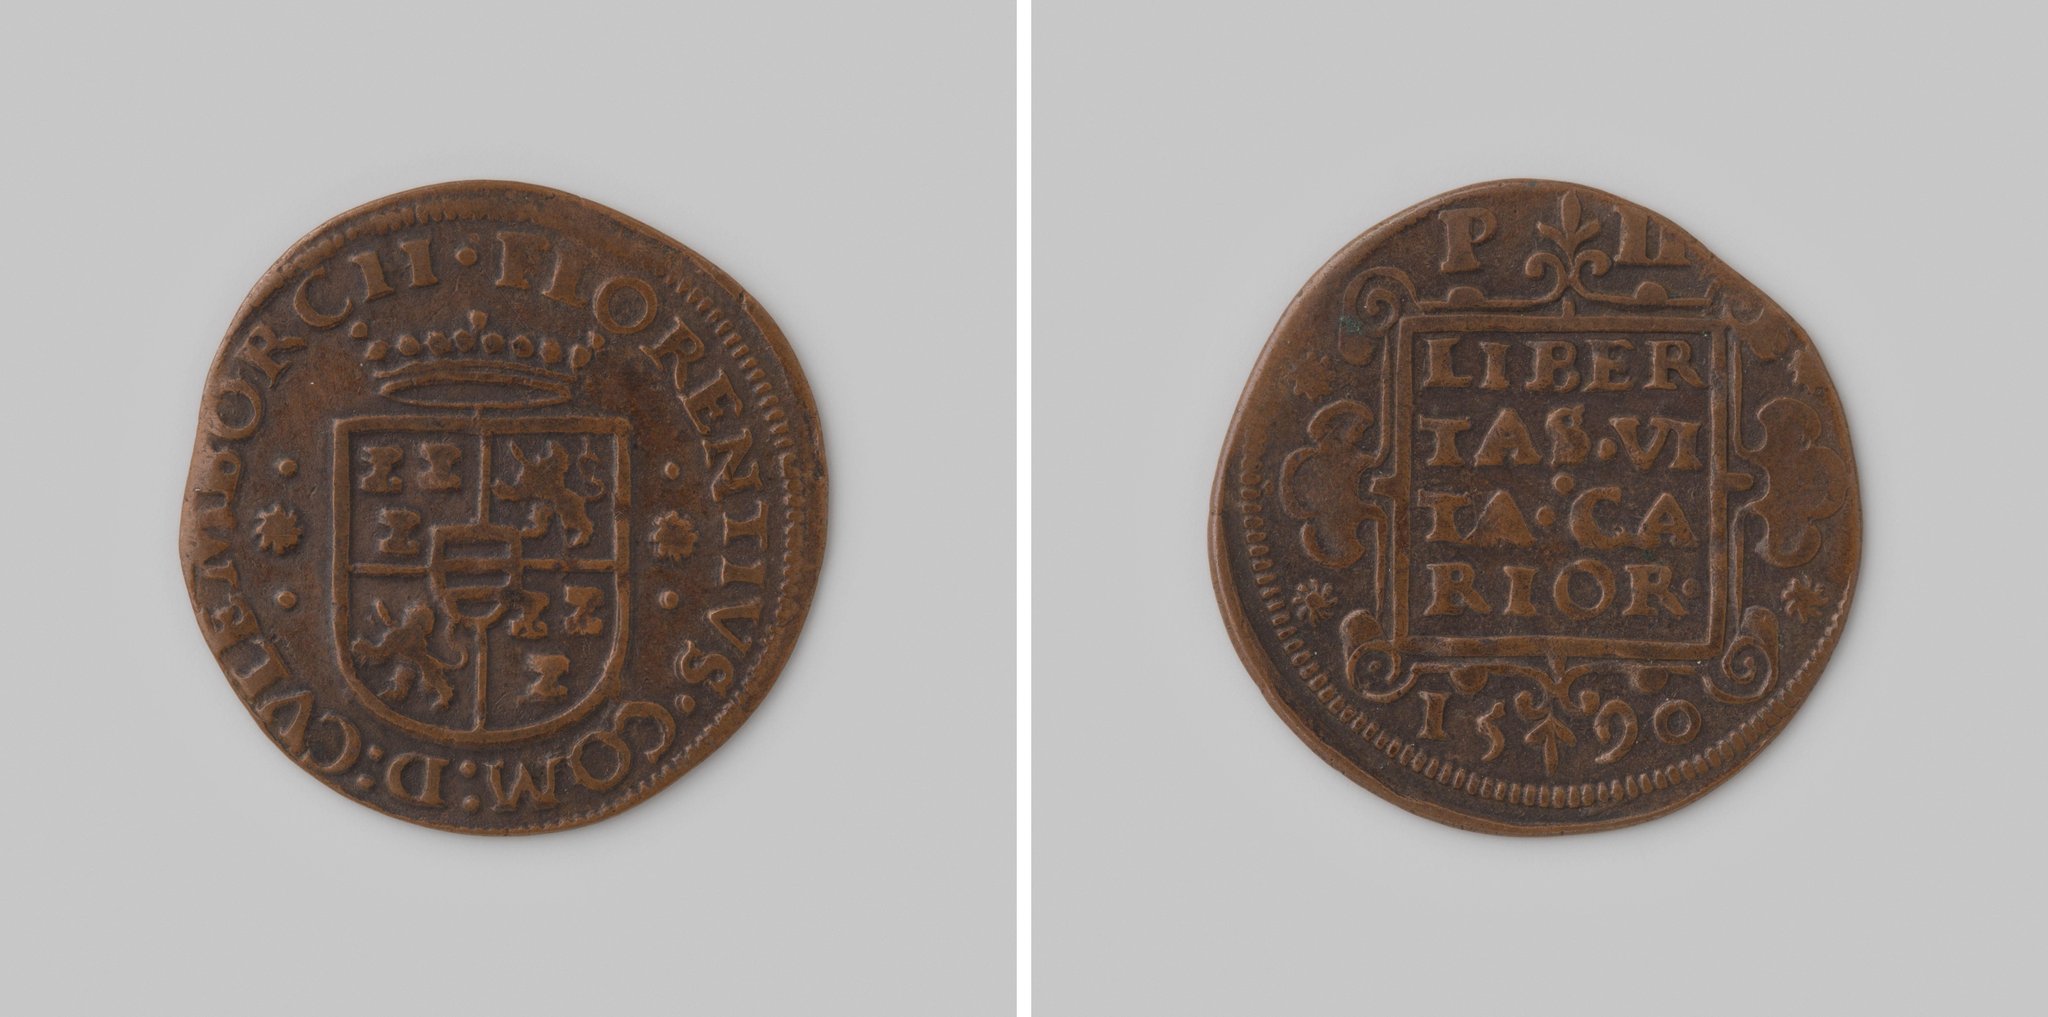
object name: coin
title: Culemborgse duit, 1590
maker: floris i van pallandt (graaf van culemborg)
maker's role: earl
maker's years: 1537-1598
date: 1590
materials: copper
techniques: striking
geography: culemborg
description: Koperen munt. Voorzijde: gekroond wapenschild van de graaf van Culemborg. Keerzijde: binnen versierd vierkant opschrift in vier regels regels. Aan bovenkant van vierkant waarde-aanduiding P II [= 2 penningen].